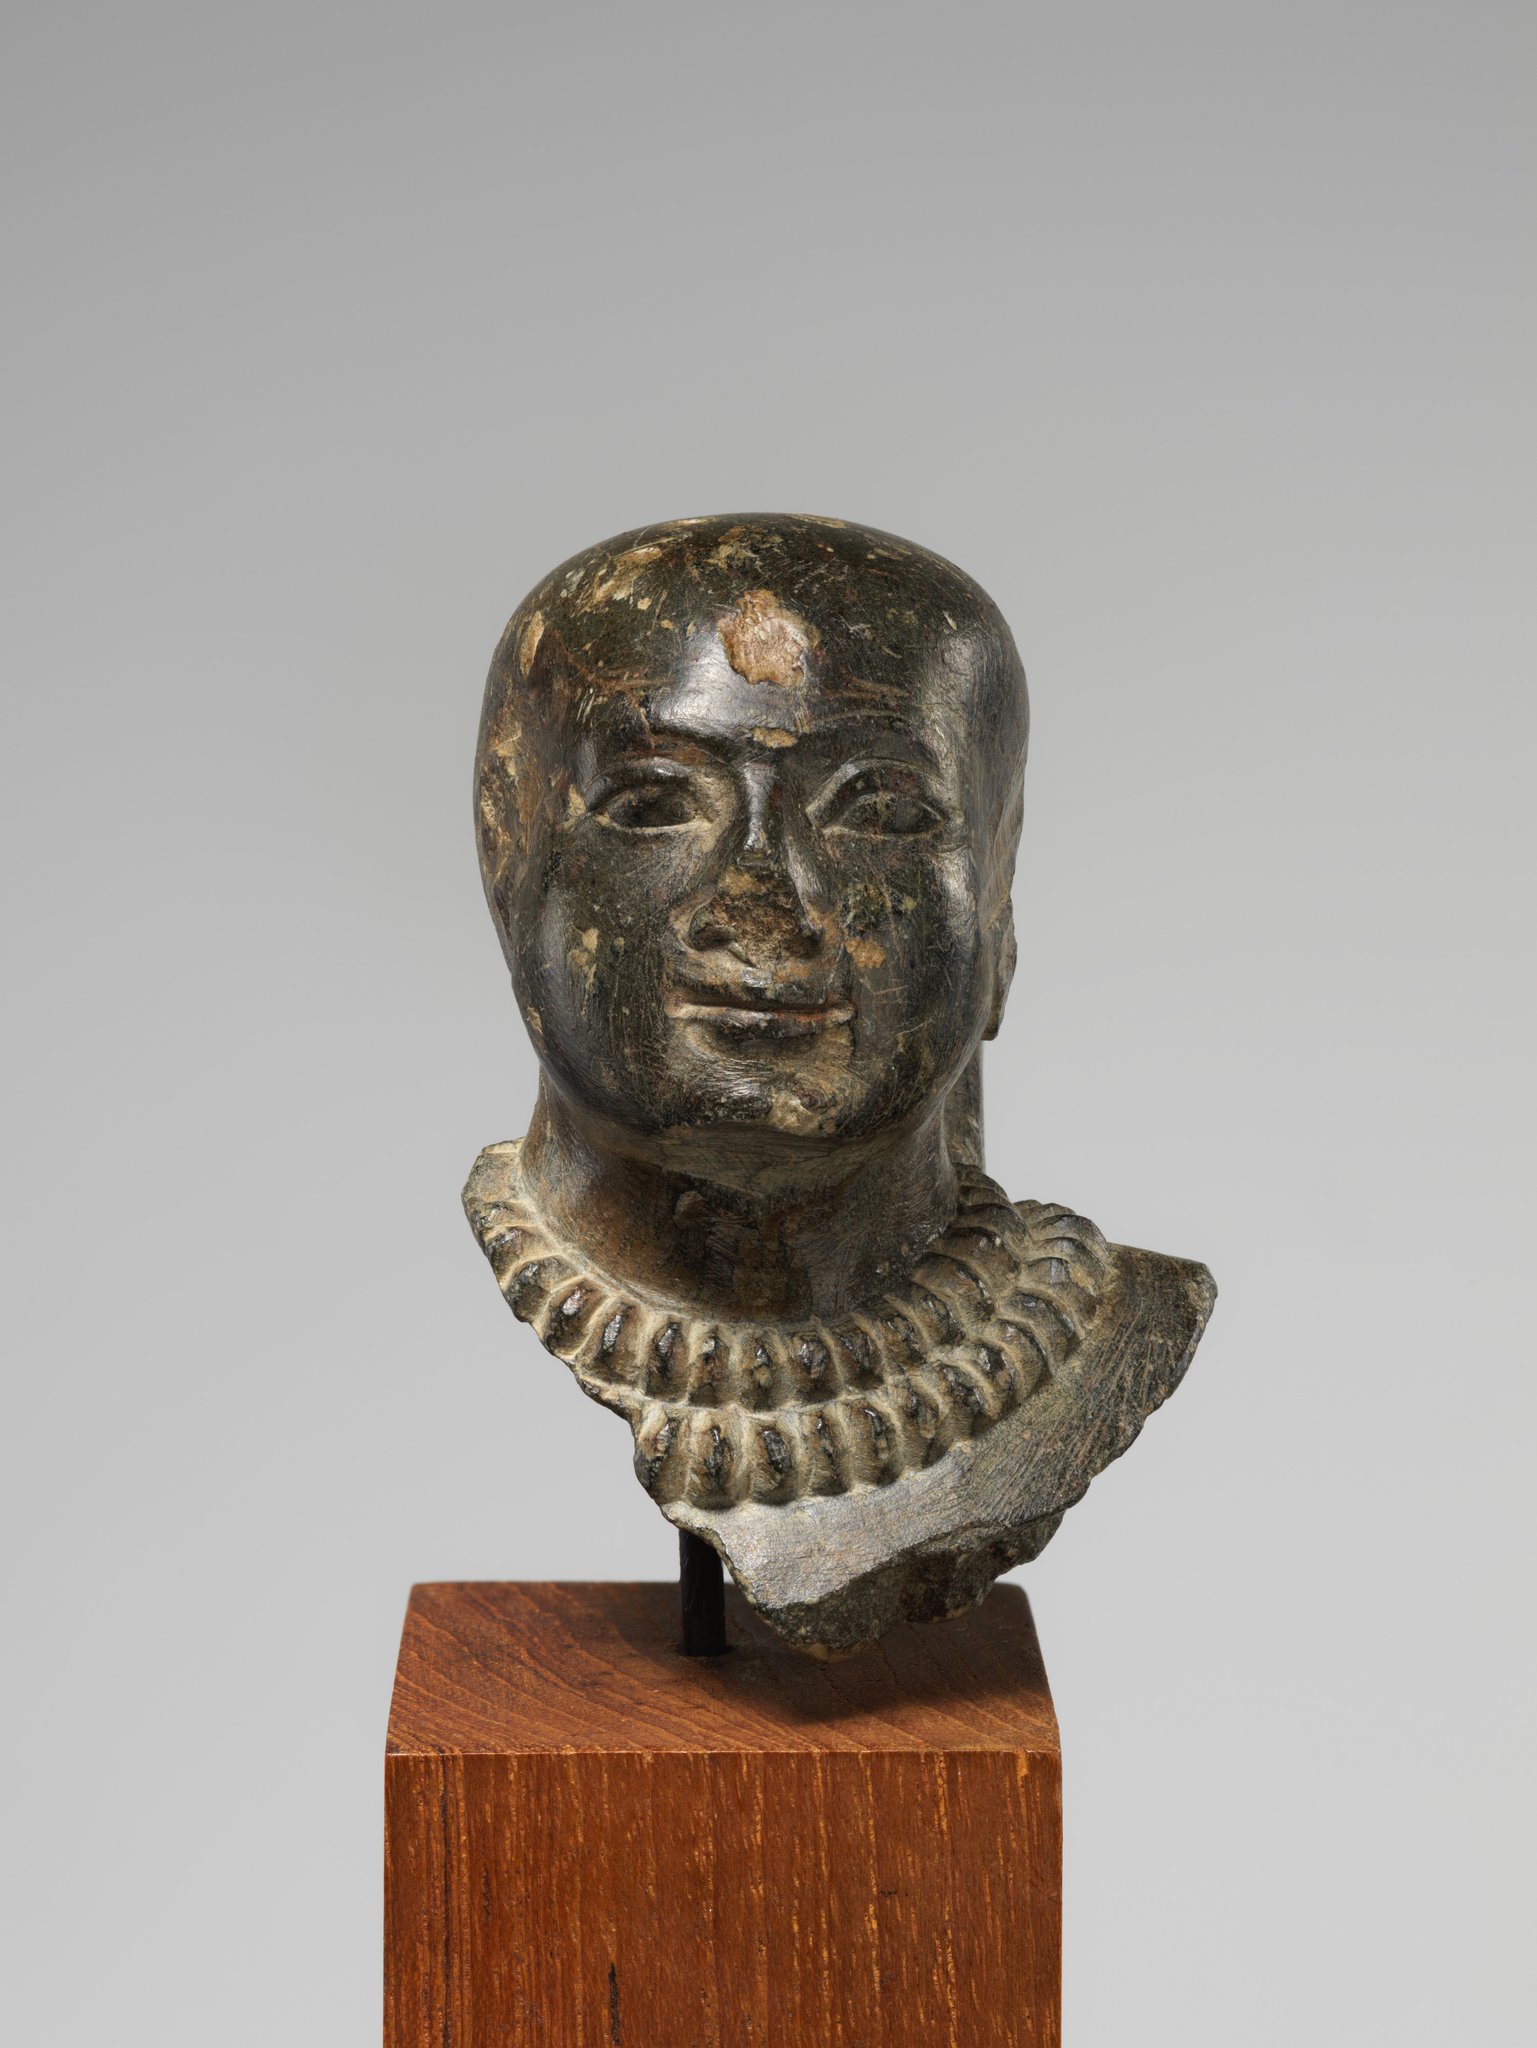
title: Bald-headed Man Wearing Gold Collars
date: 1295-1186 BCE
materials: stone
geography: egypt